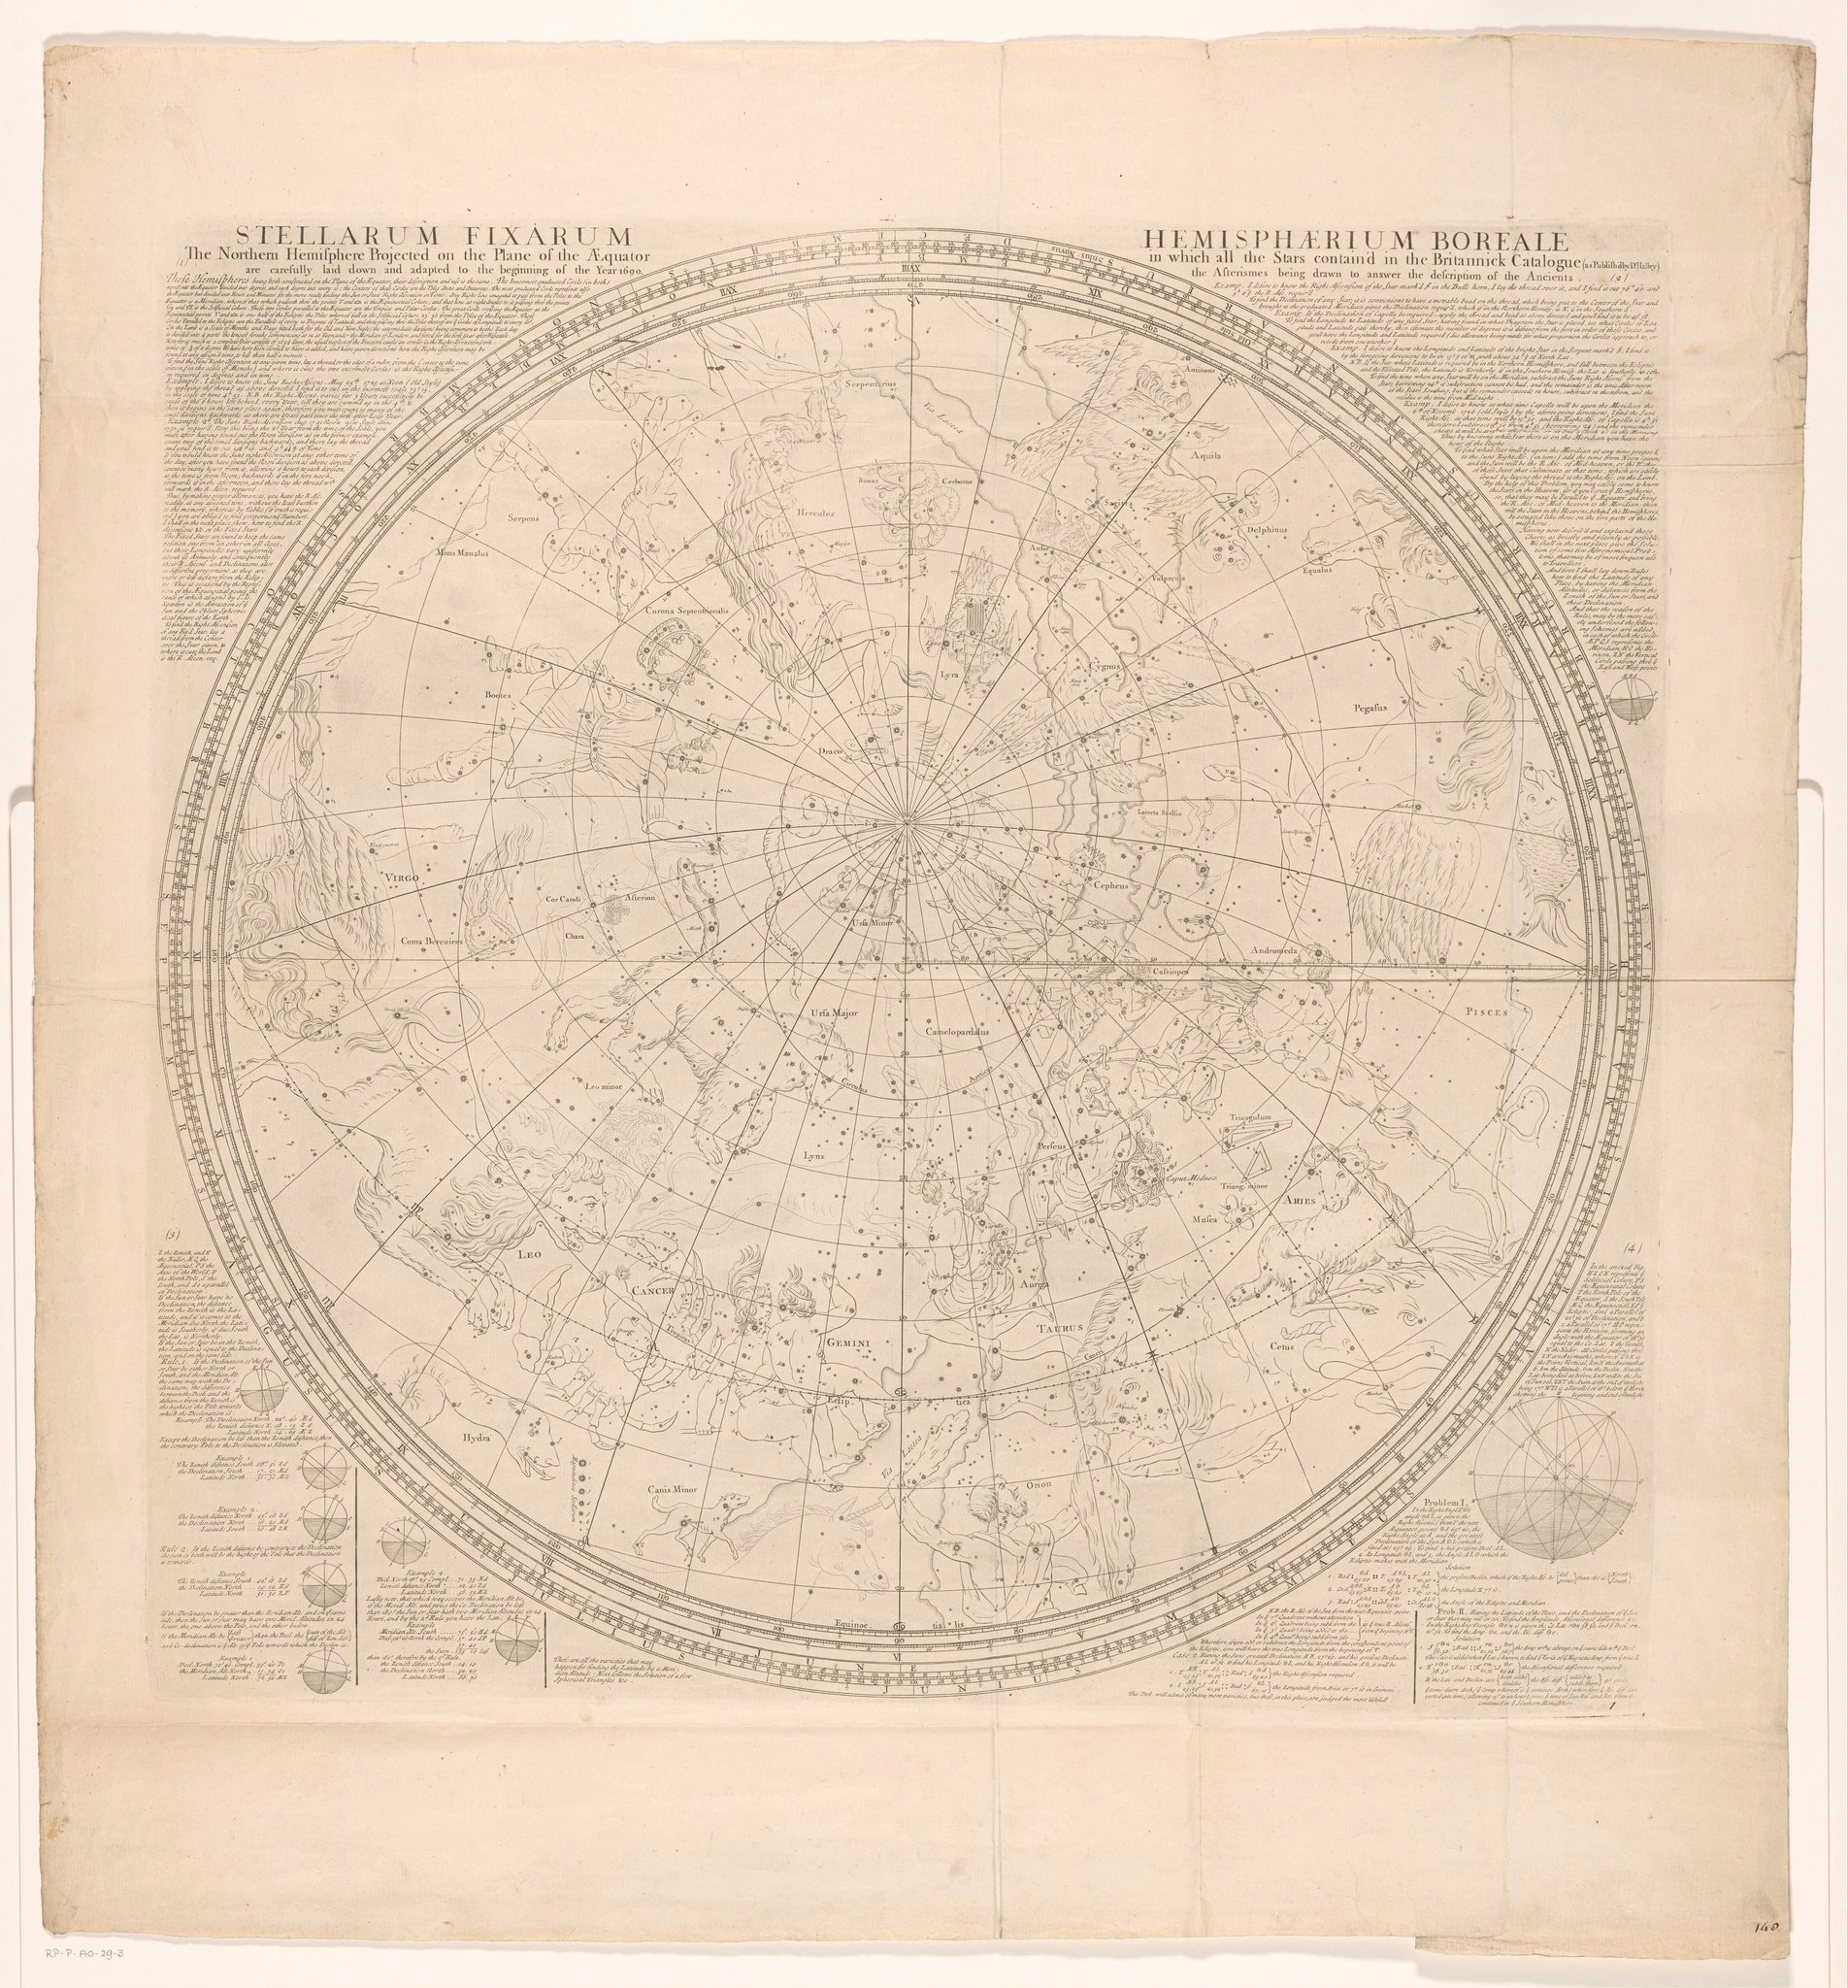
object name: print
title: Hemelkaart met de noordelijke sterrenbeelden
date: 1721-1728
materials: paper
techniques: engraving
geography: london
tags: zodiac; the twelve zodiacal signs together, star-chart, star map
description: Hemelkaart van de noordelijke sterrenbeelden. De positie van de sterren is gebaseerd op de sterrencatalogus van Halley (in feite overgenomen van Flamsteed). De kaart is voorzien van een rooster en gradenverdelingen. In de hoeken van de kaart uitleg van de astronomie.